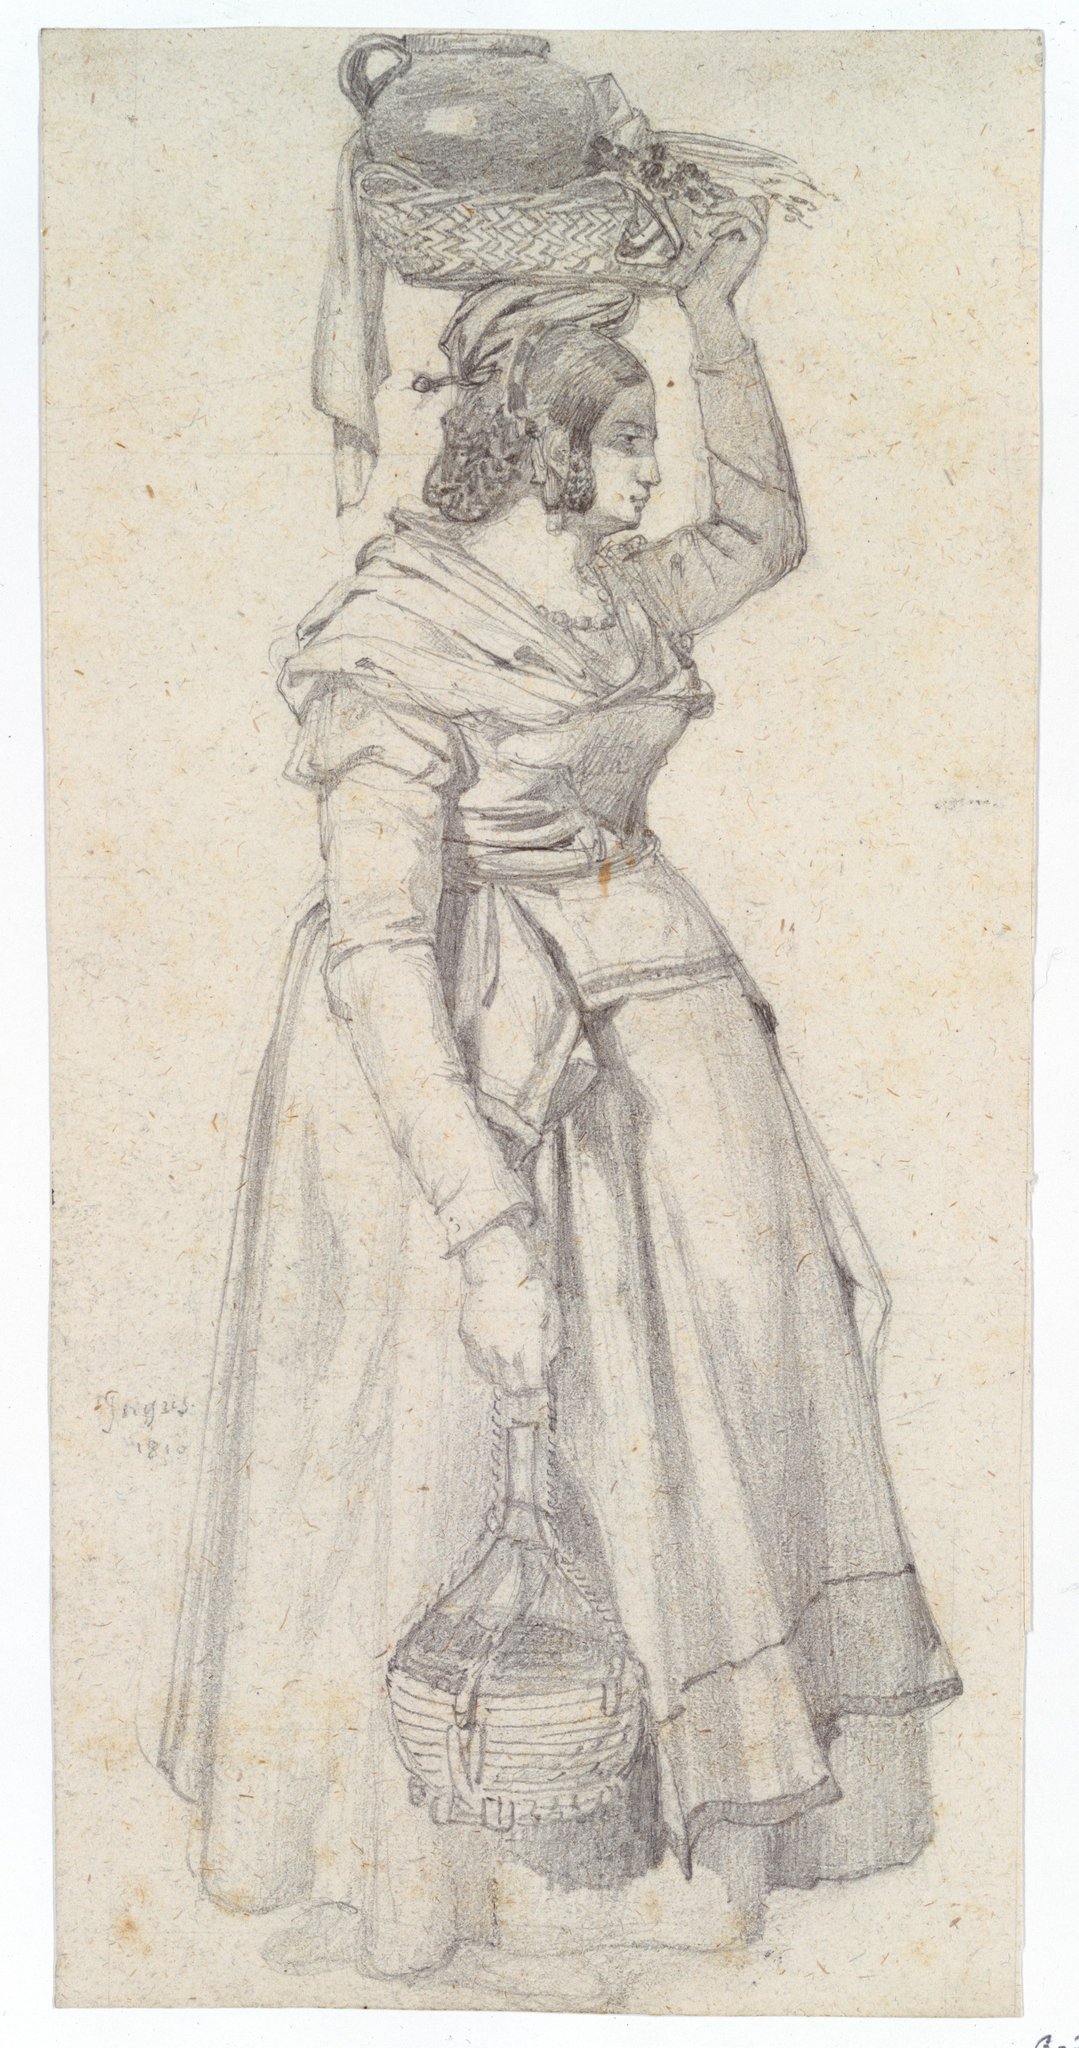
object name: drawing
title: Italian Peasant Woman with Basket on her Head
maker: northern european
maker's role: artist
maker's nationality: northern european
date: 1820-1840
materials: fiber, graphite, paper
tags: women,baskets